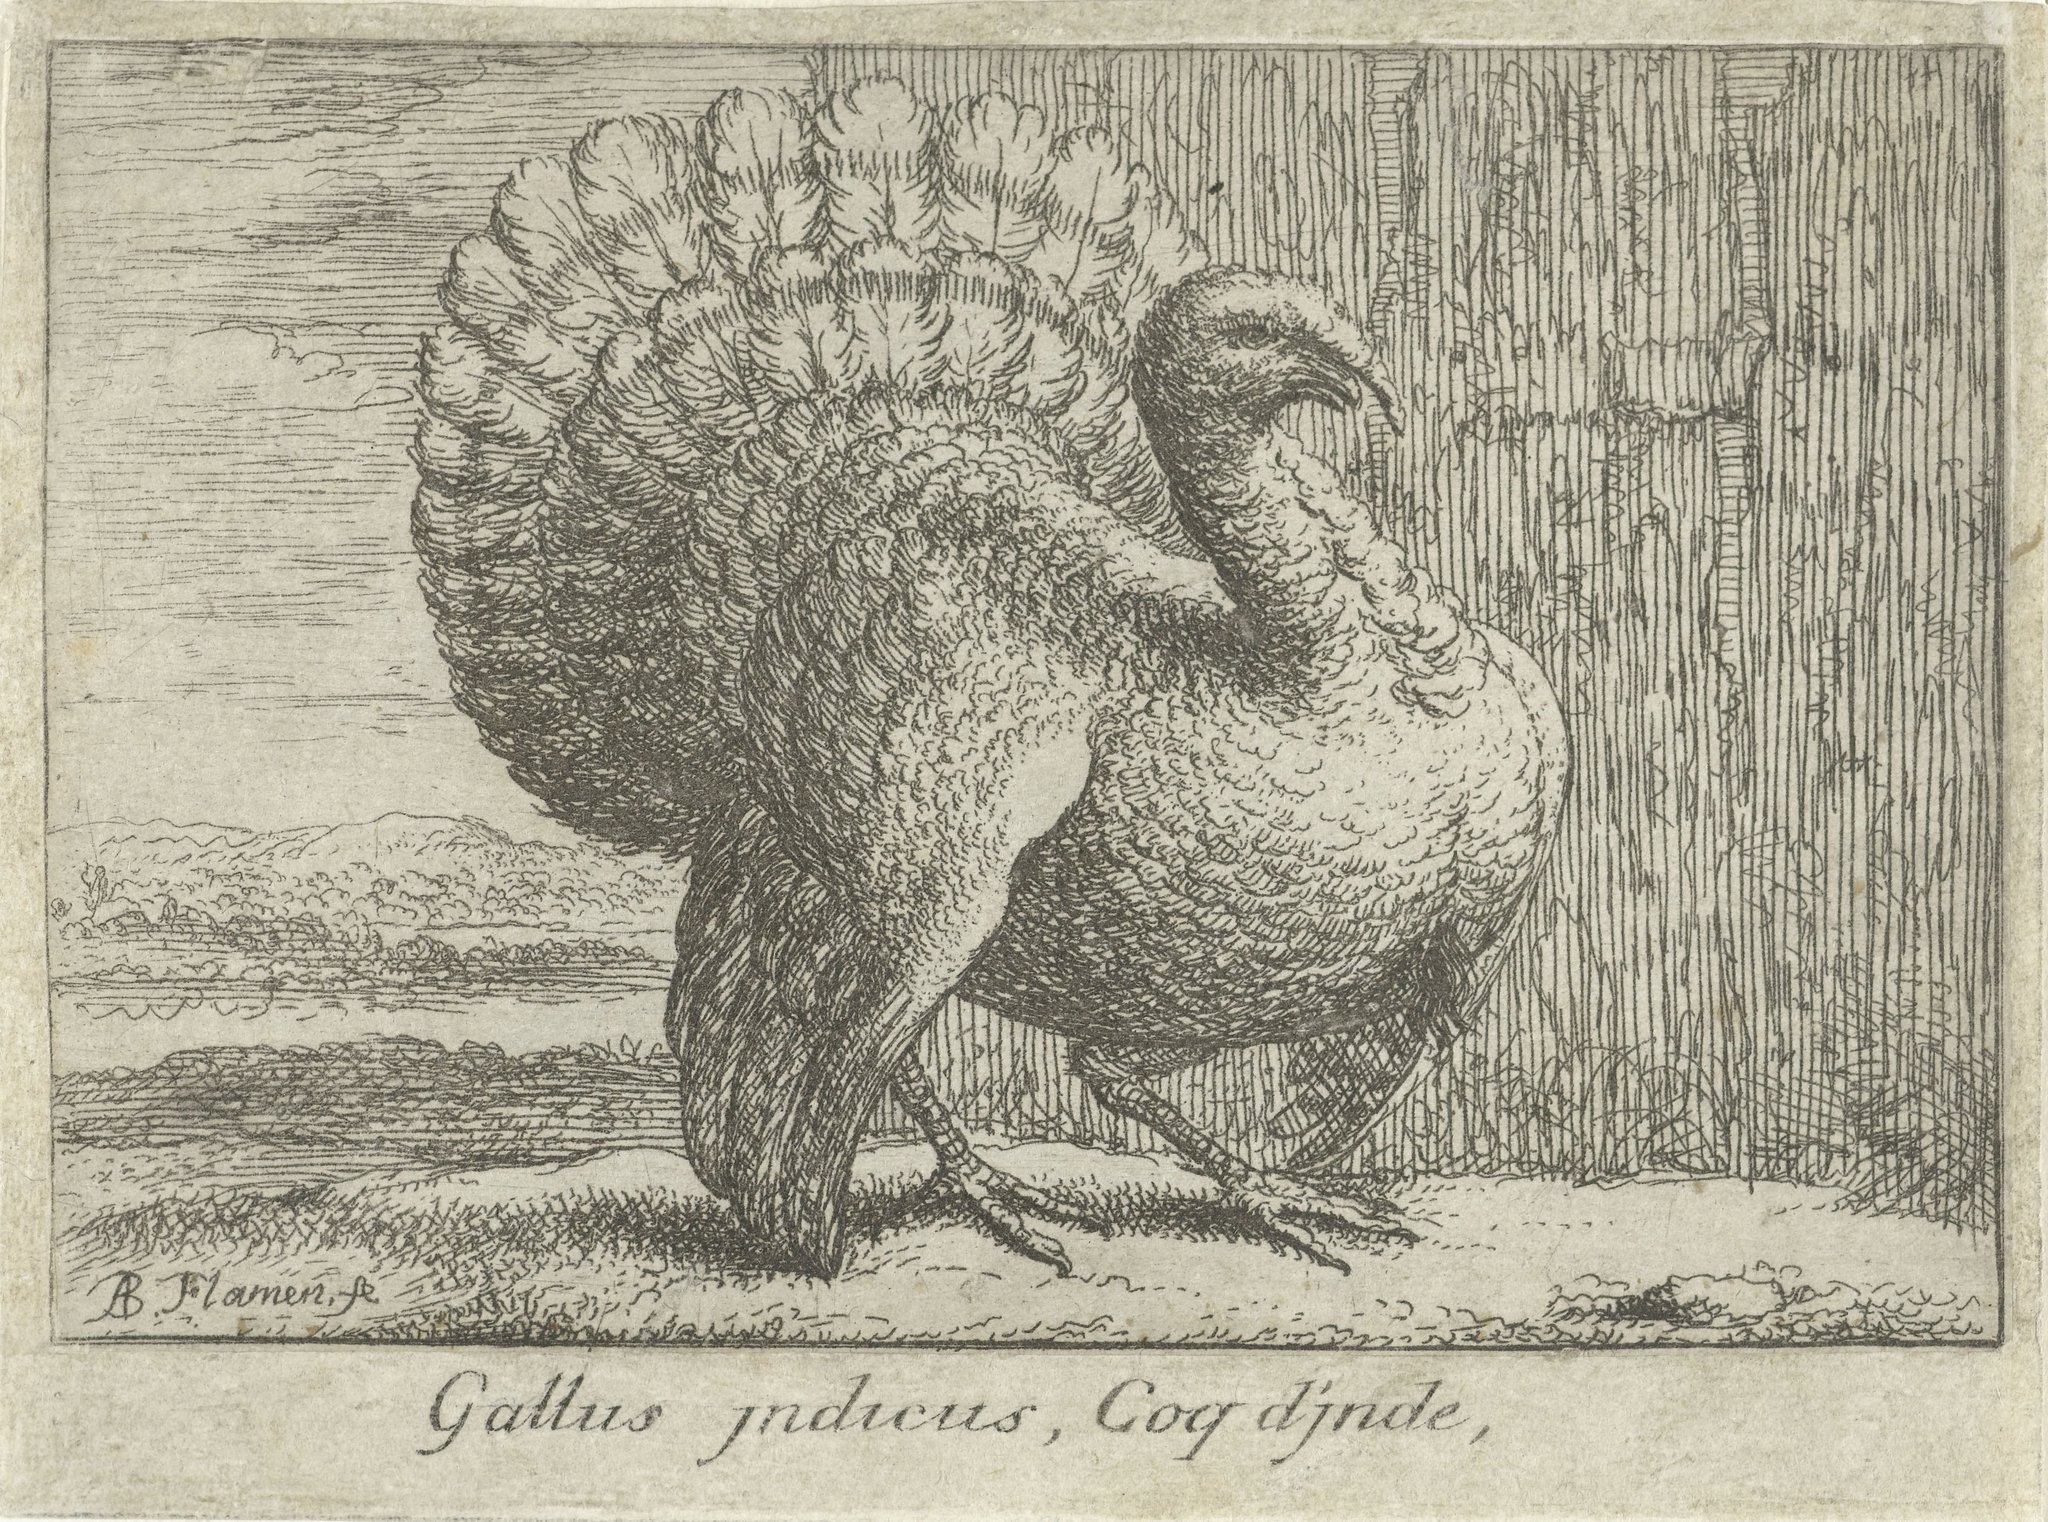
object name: print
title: Dertien vogelsoorten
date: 1659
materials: paper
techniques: etching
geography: paris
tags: walker and runner birds: turkey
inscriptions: collector's mark: Lugt 2228